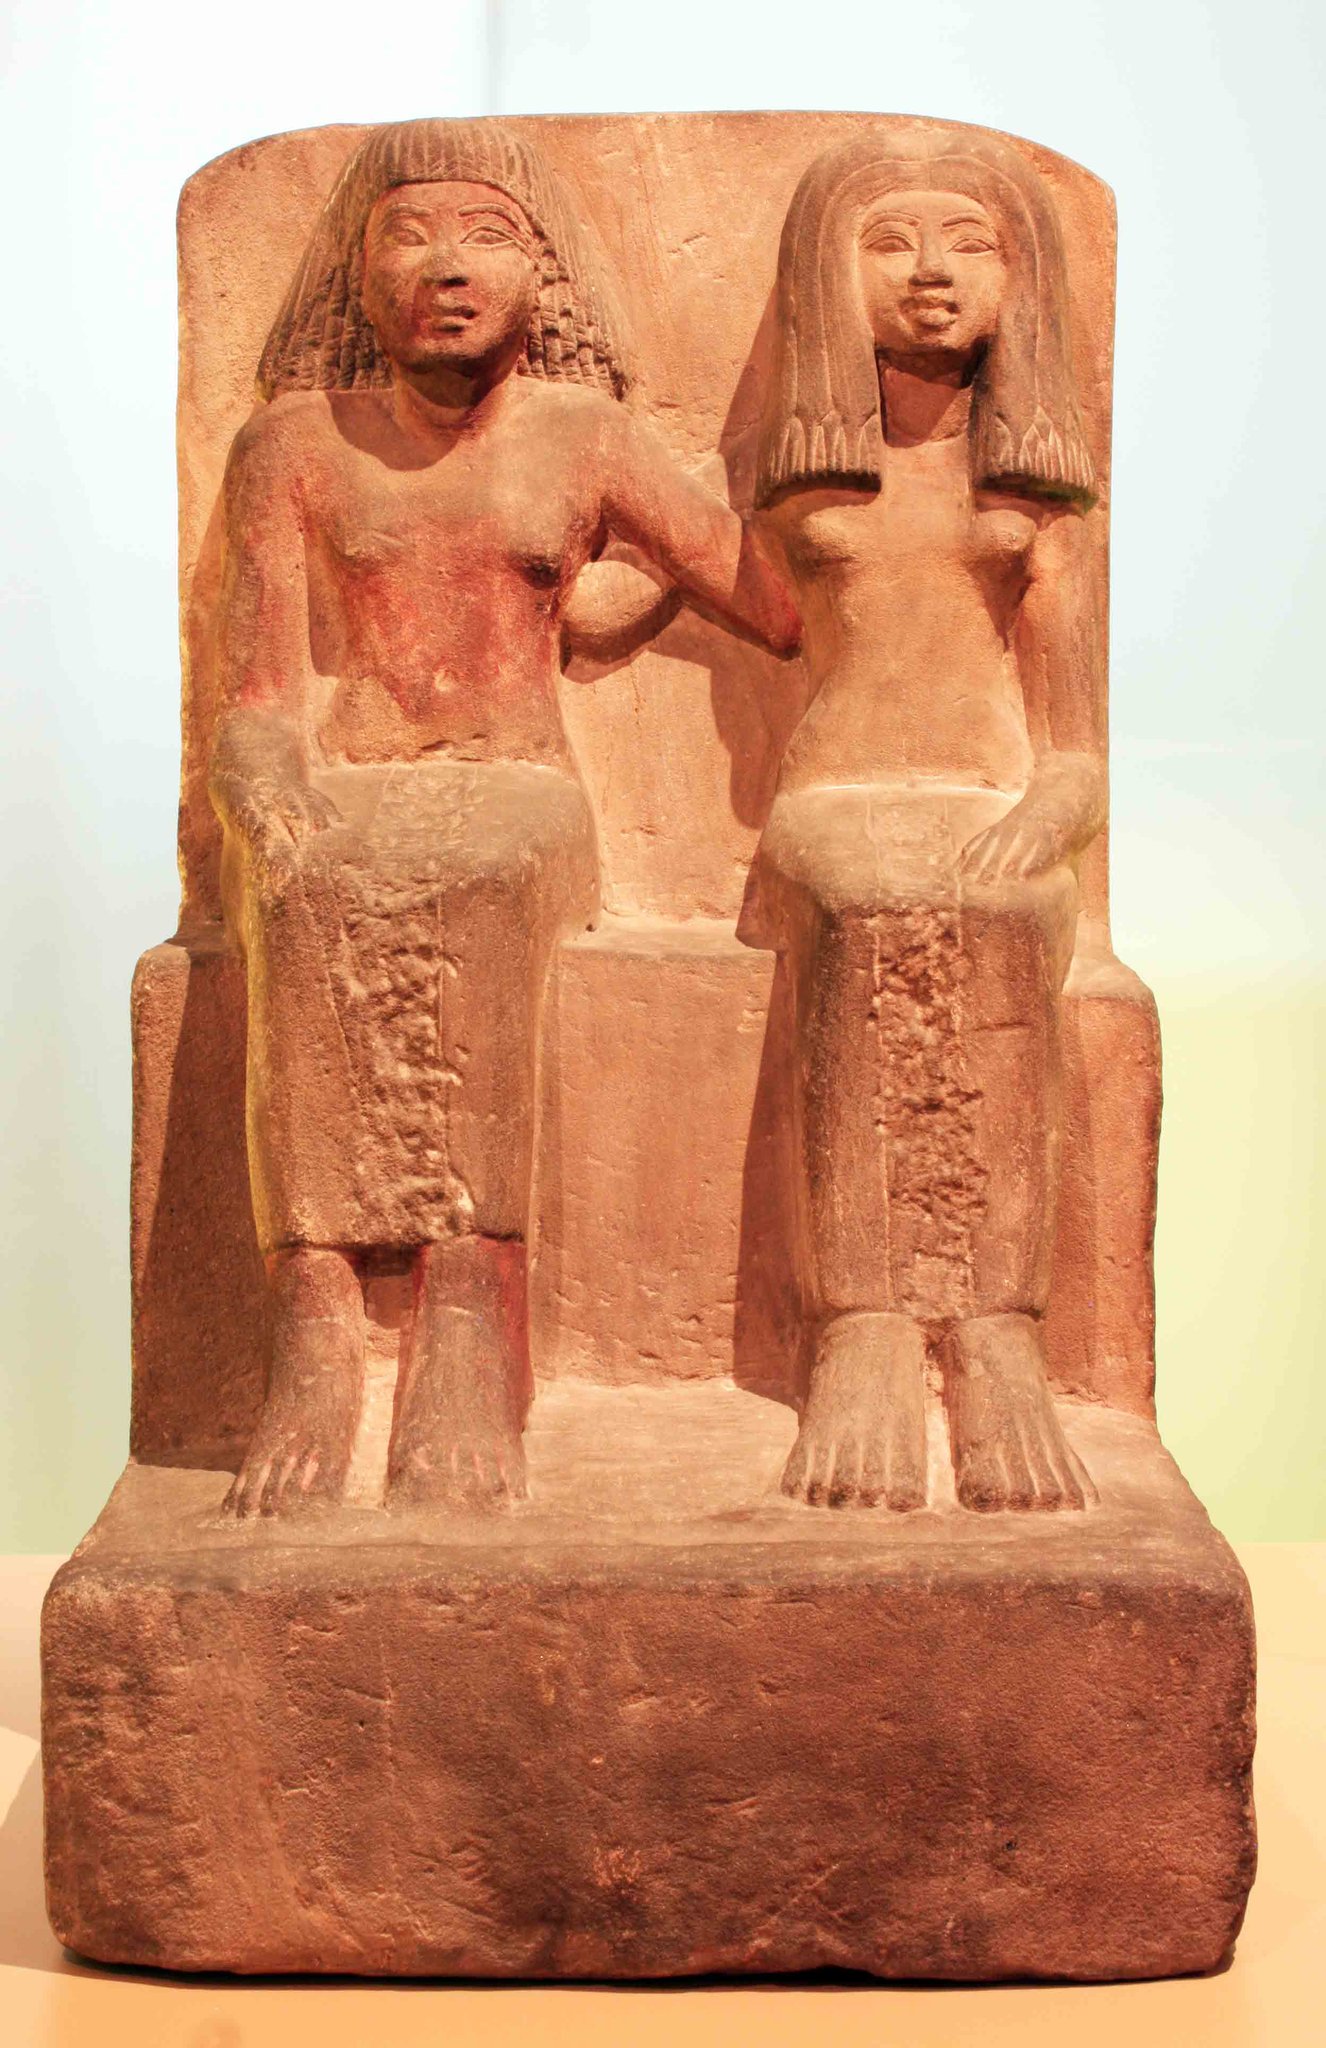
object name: statue, pair, nebwaw, tenethet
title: Pair Statue of Nebwaw and His Wife, Tenethet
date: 1390-1295 BCE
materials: paint, stone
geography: egypt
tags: men,women